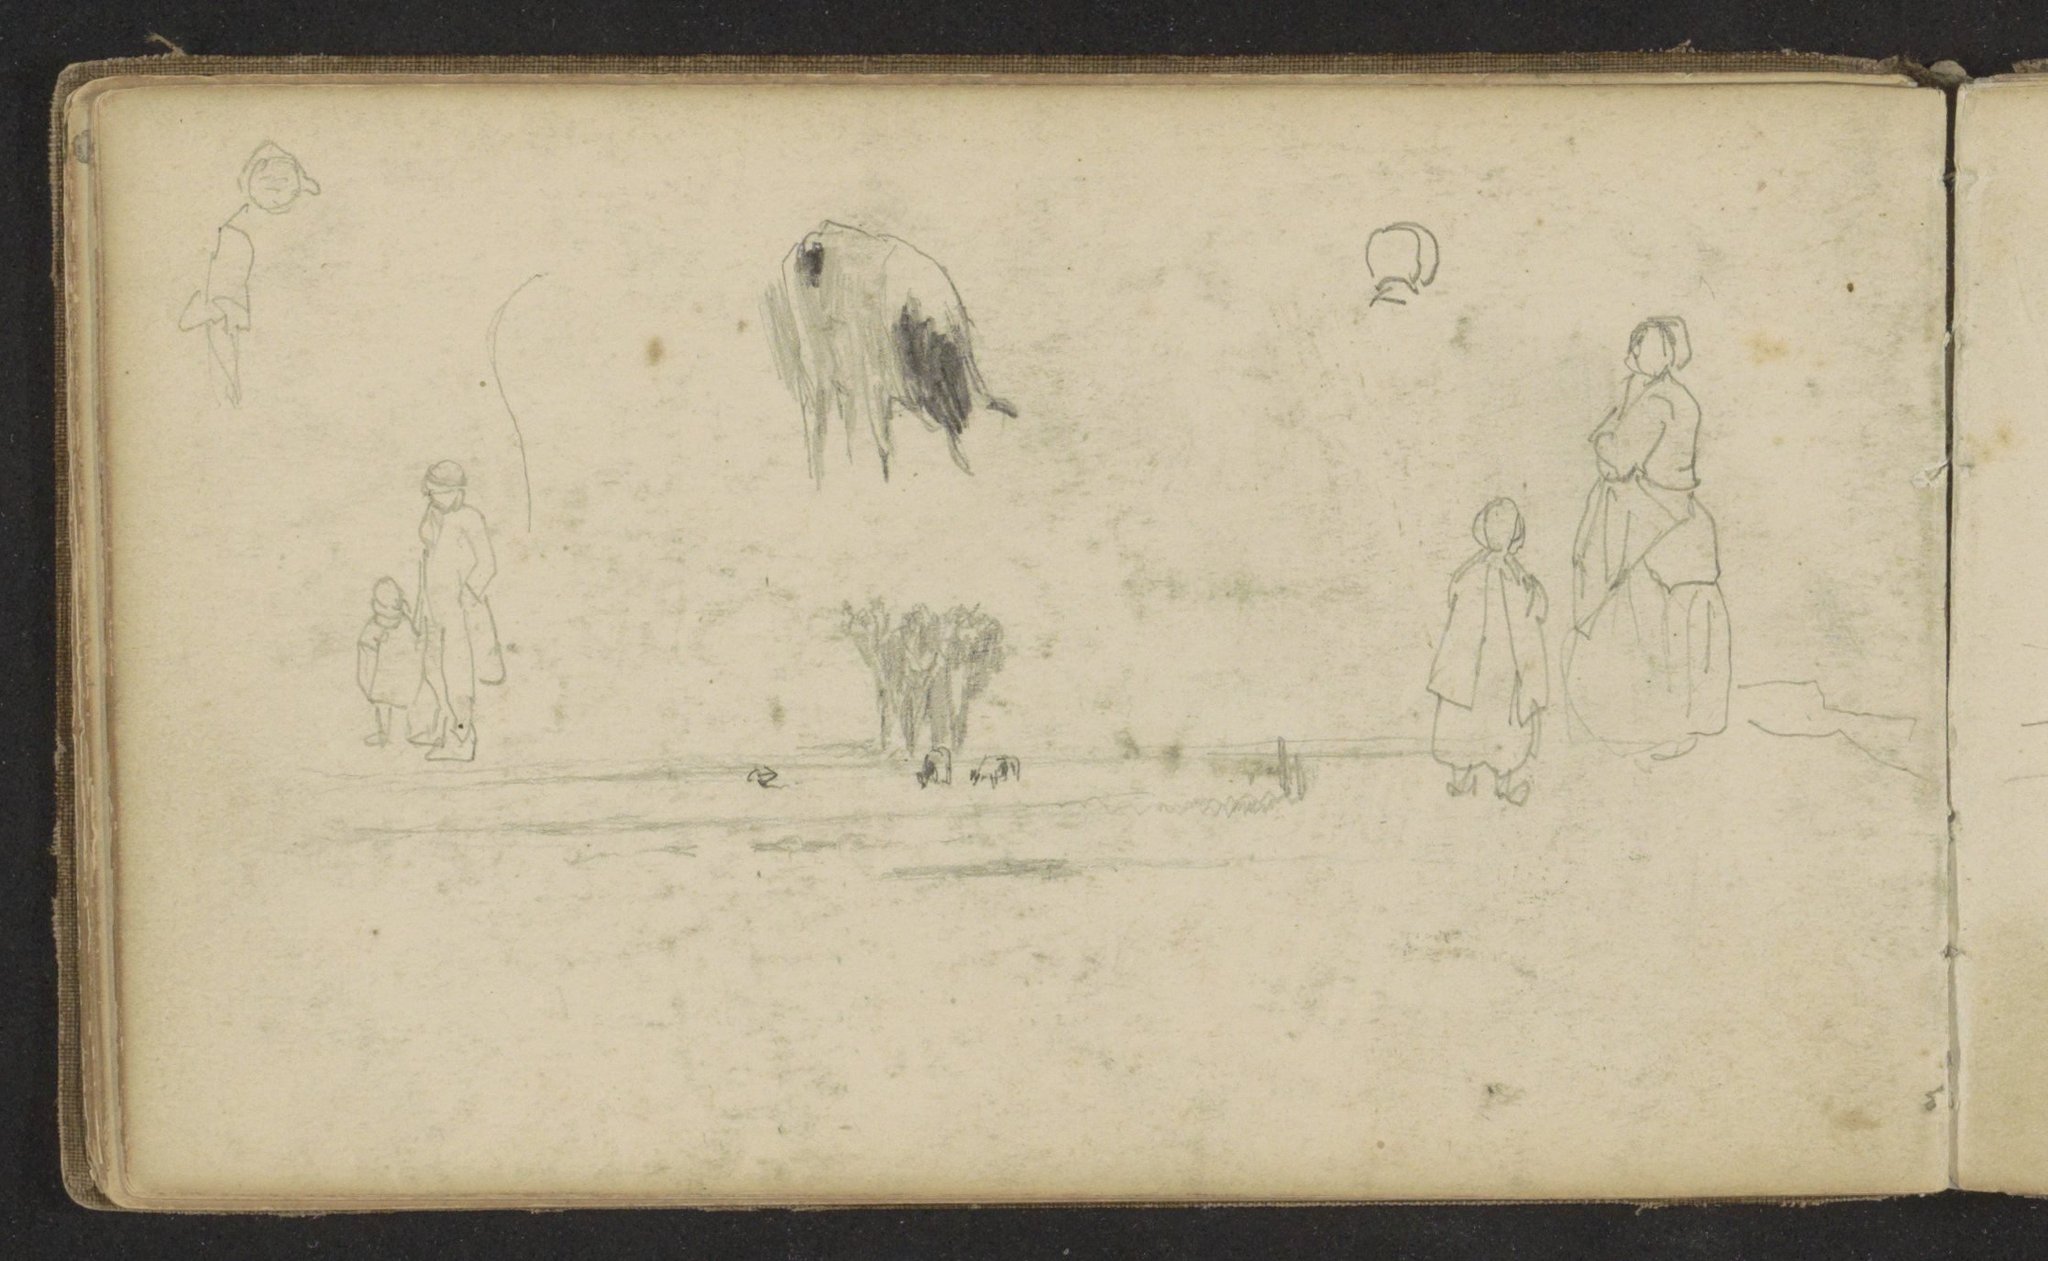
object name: sketchbook leaf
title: Koeien in een weiland, een koe en figuurstudies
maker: johan hendrik weissenbruch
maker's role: draughtsman, painter, print maker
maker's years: 1824-1903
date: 1834-1903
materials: paper, pencil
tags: cow, anatomy (non-medical), meadow, pasture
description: Studies van een man, vrouw en kinderen op klompen. Blad 16 verso uit een schetsboek met 43 bladen.